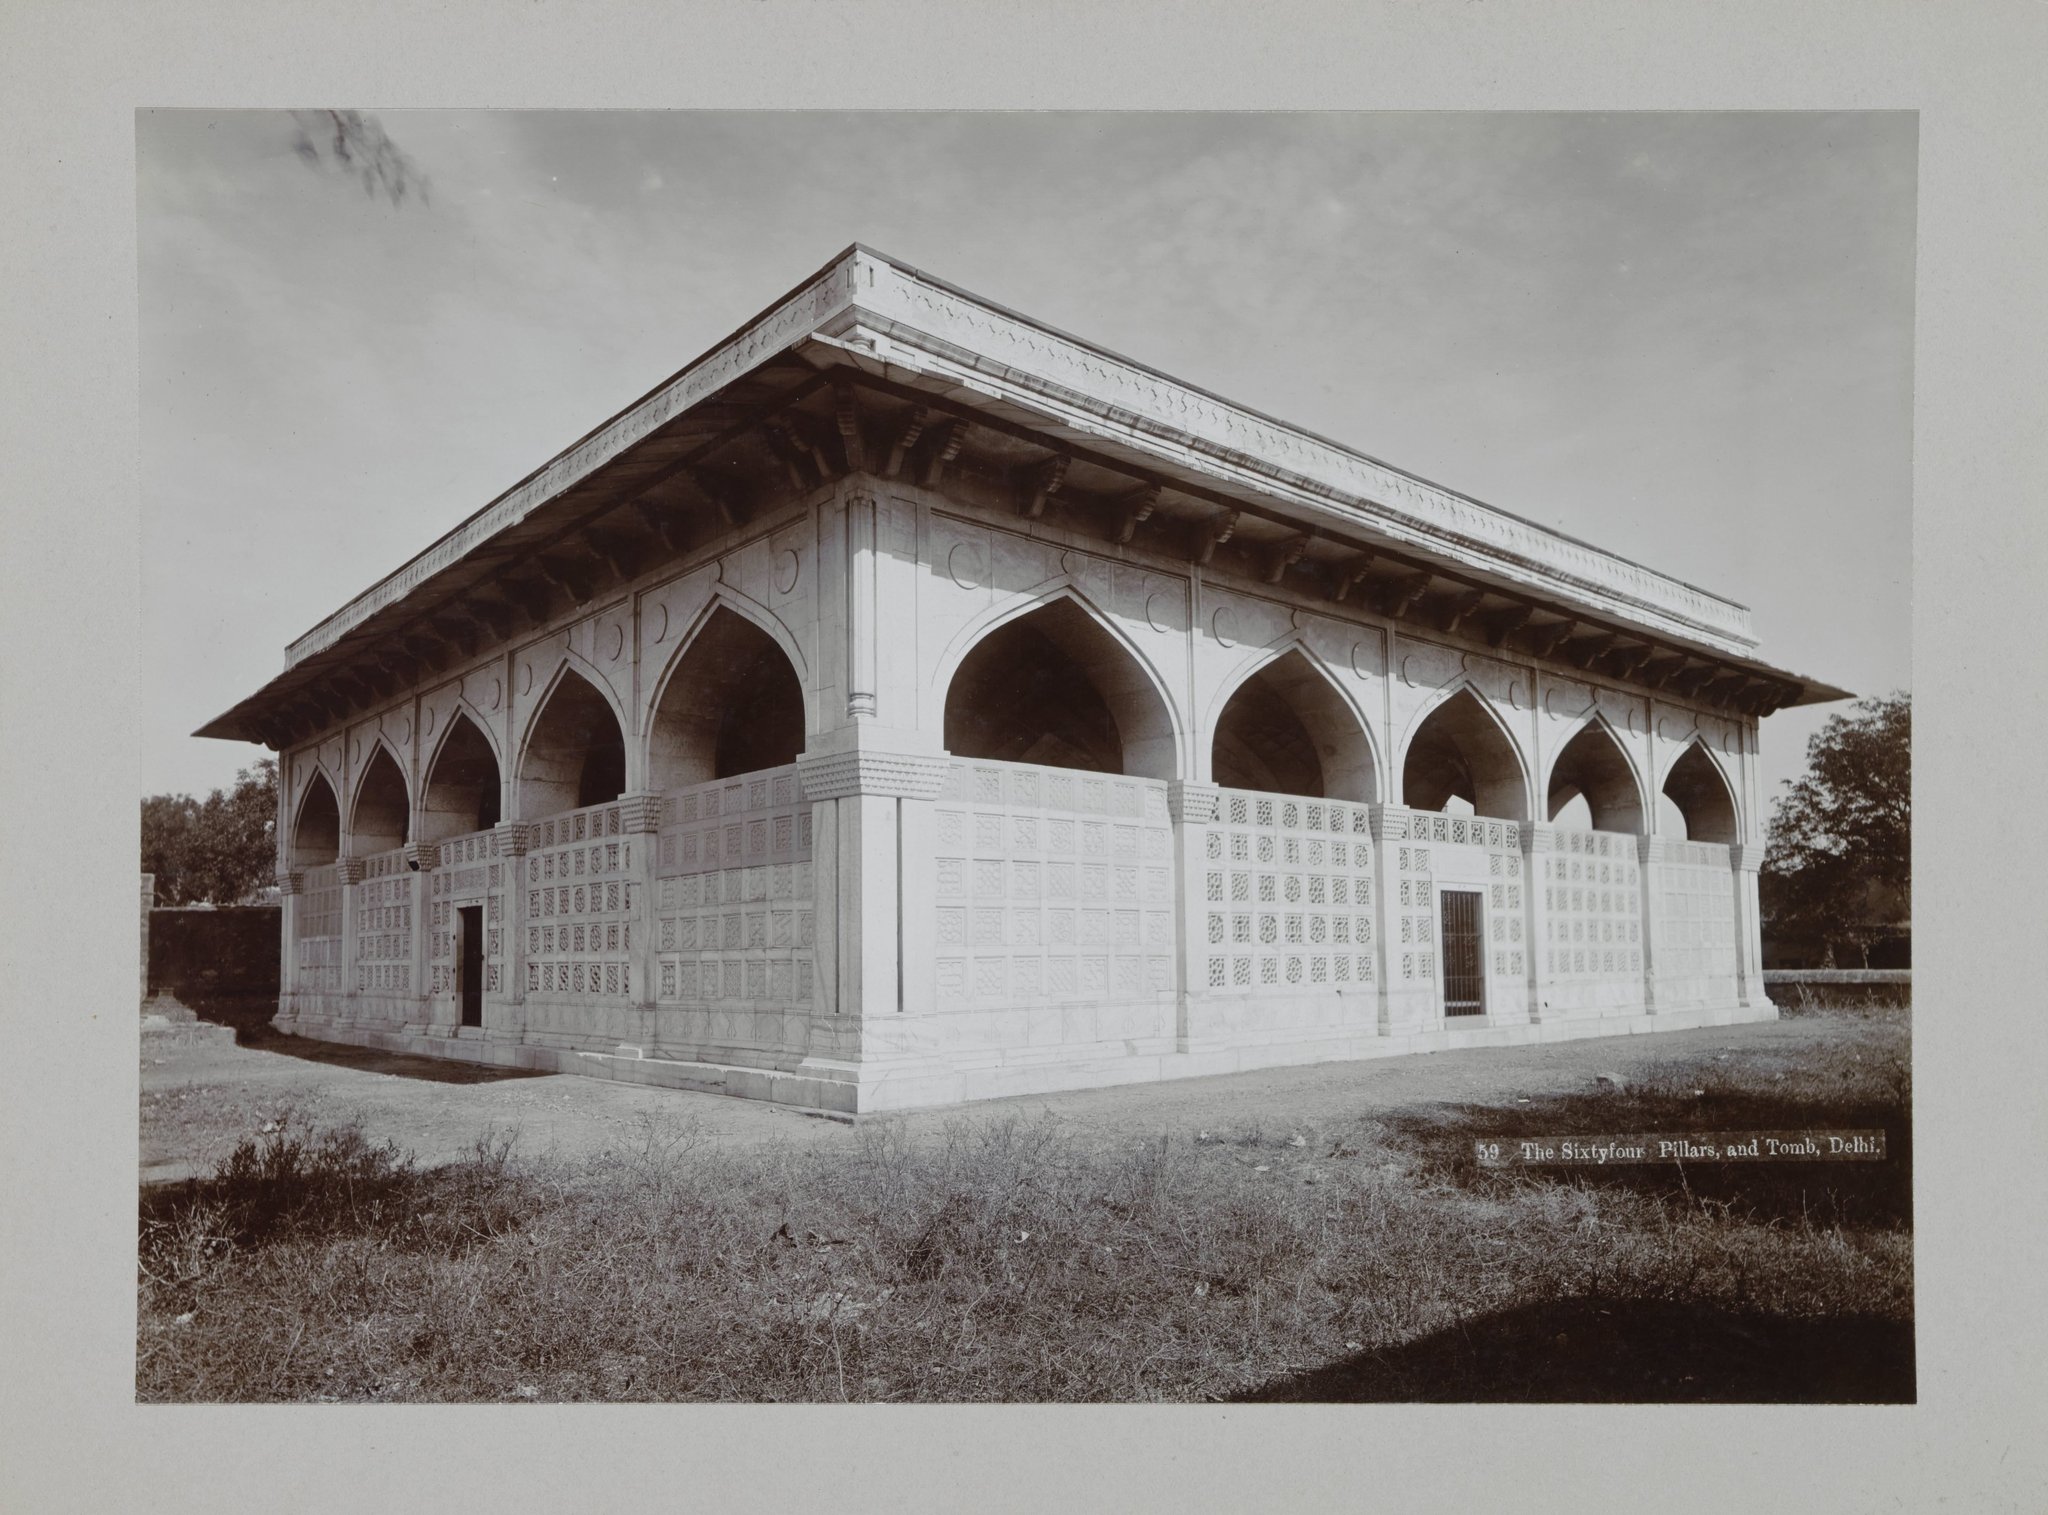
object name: photograph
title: Chausath Khamba Tomb, Delhi, India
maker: Anonymous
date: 1895-1915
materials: cardboard, paper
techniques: gelatin silver print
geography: delhi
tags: delhi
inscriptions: number: ‘40.’, inscription: ‘59 The Sixtyfour Pillars, and Tomb, Delhi.’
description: De tombe Chausath Khambah, opgebouwd uit 64 pilaren.